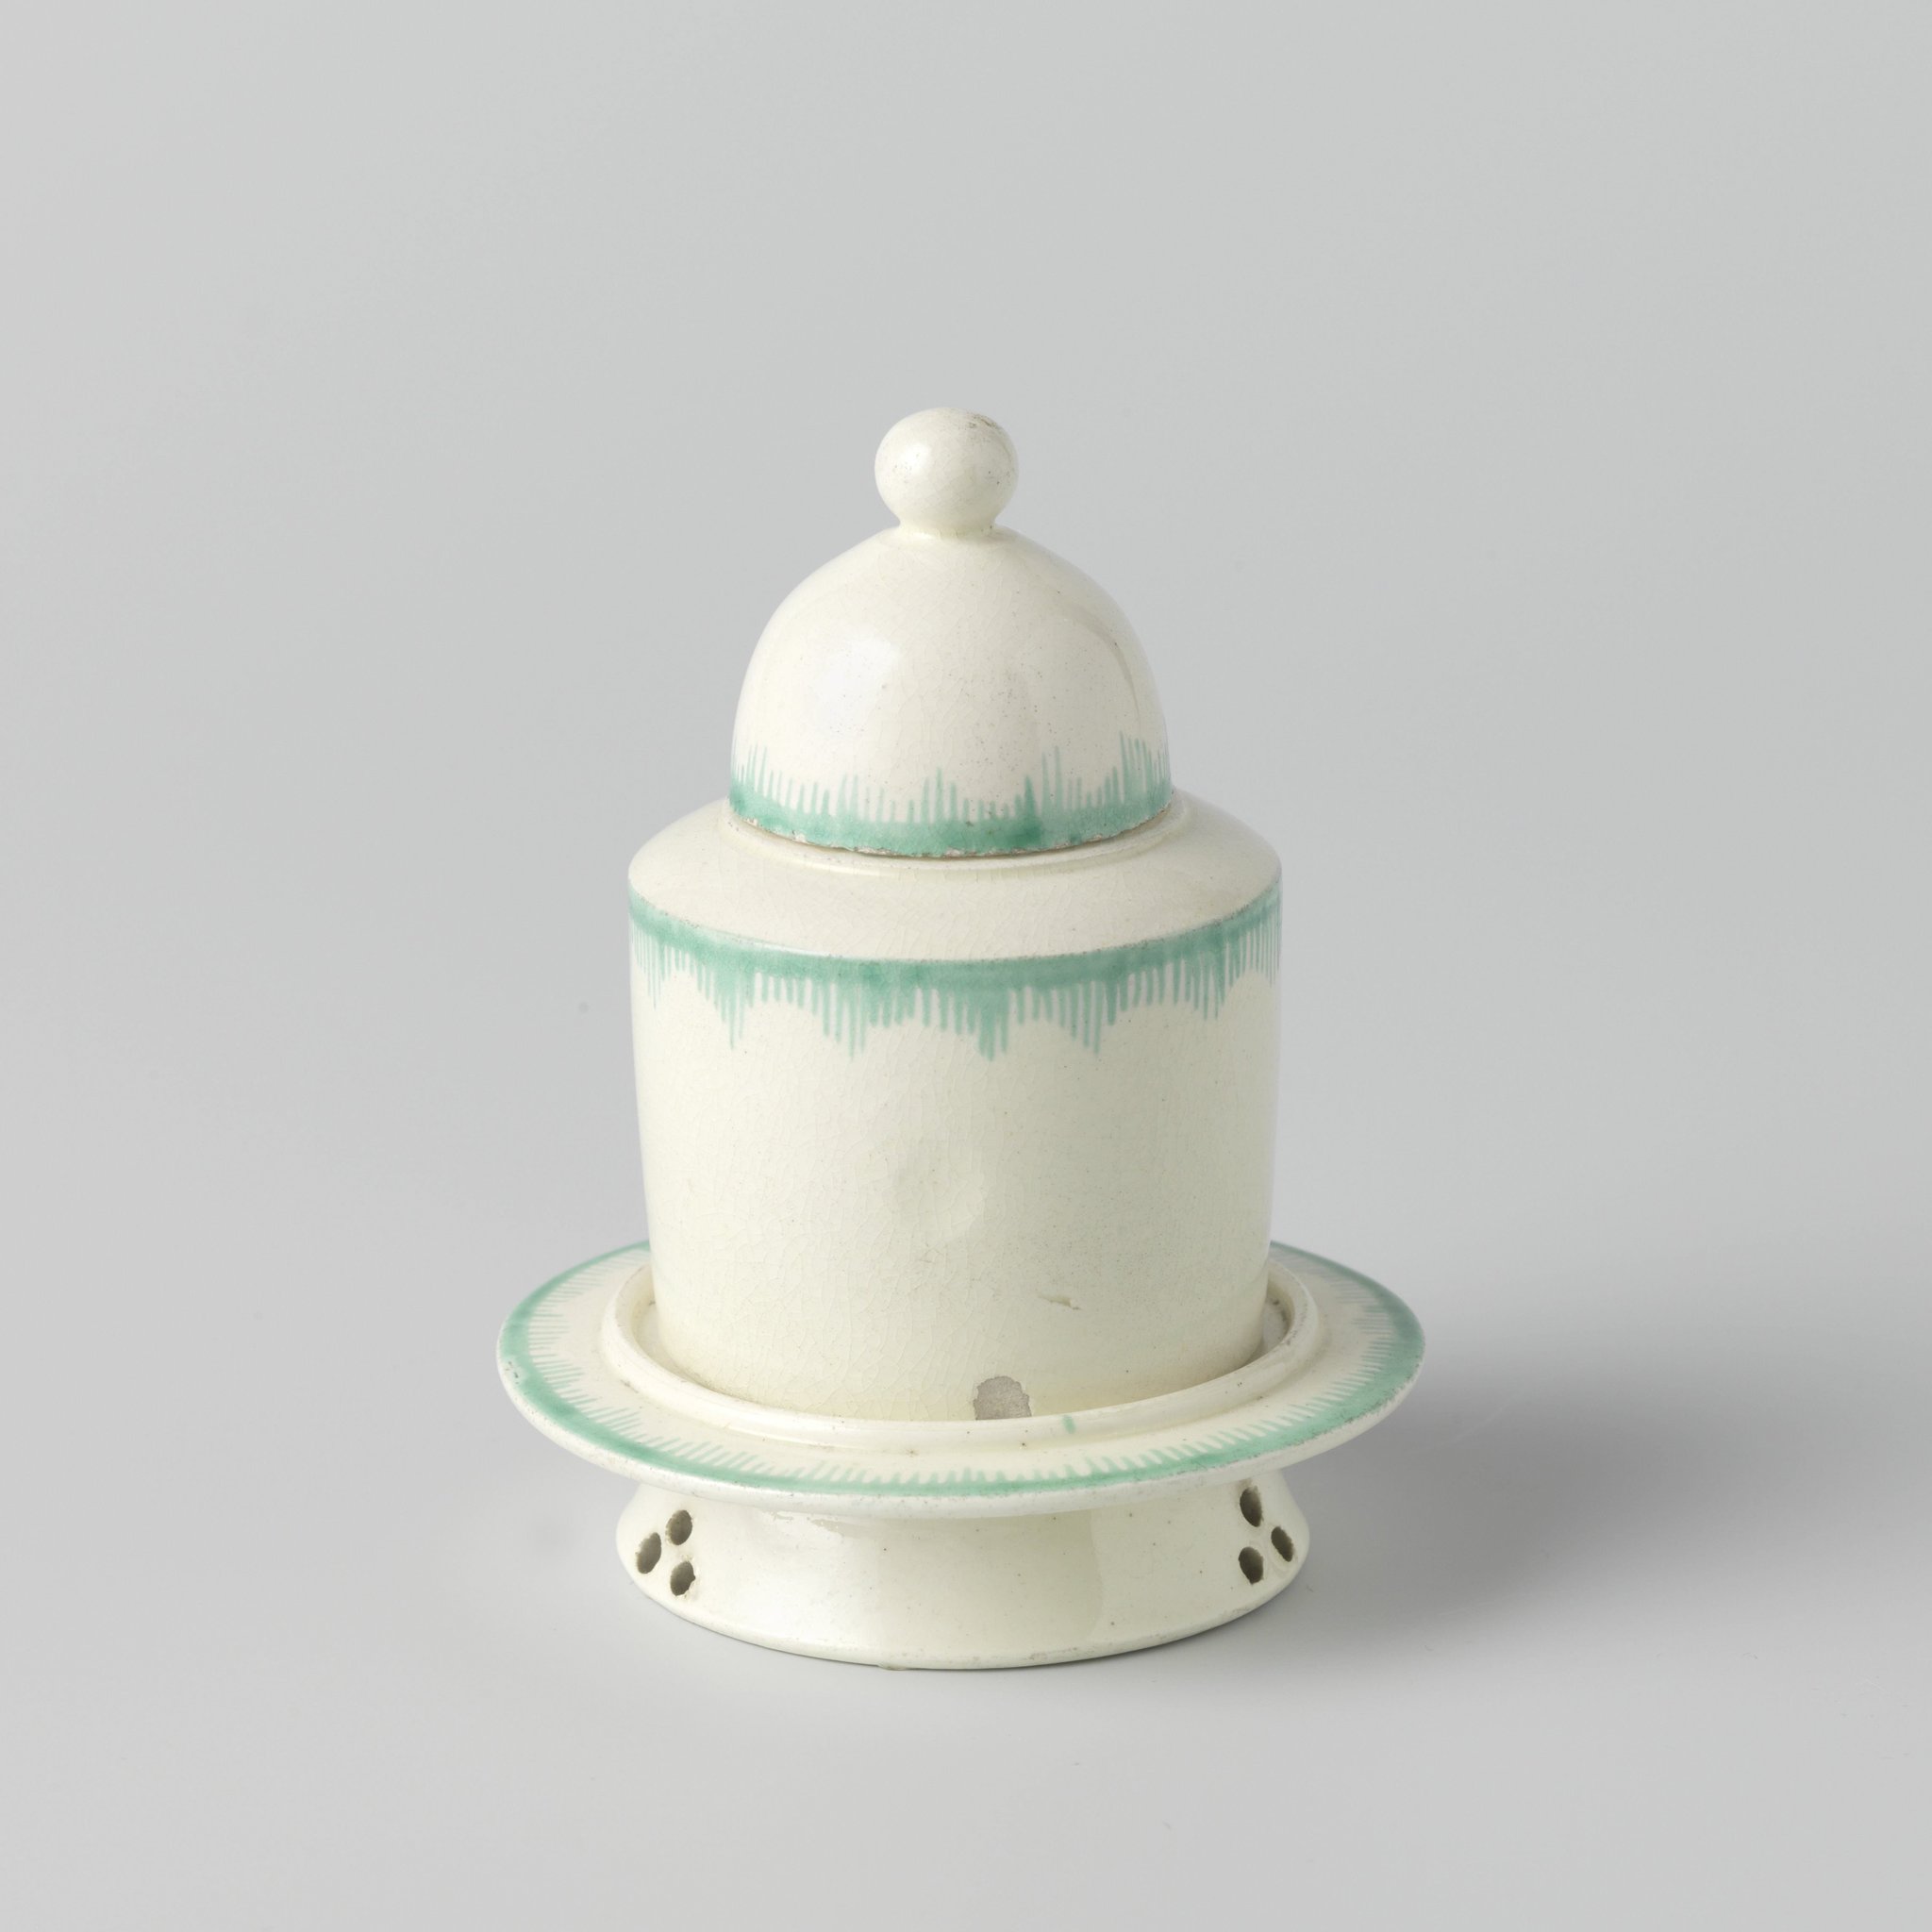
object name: bus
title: Theebus met deksel op onderschotel van hardgebakken aardewerk, creamware.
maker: Anonymous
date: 1790-1810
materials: earthenware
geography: england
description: Theebus van hardgebakken aardewerk, van een kinderservies. De theebus is cilindrisch, het deksel is gewelfd en heeft een bolvorvormige knop. De theebus staat op een onderschotel in de vorm van een voetstuk met op het standvlak driemaal een opengewerkte driepas. De dekselrand en de rand van de bus zijn versierd met een groen uitstralende rand. De theebus hoort bij vier kop en schotels (BK-NM-11012-A t/m BK-NM-11012-D).